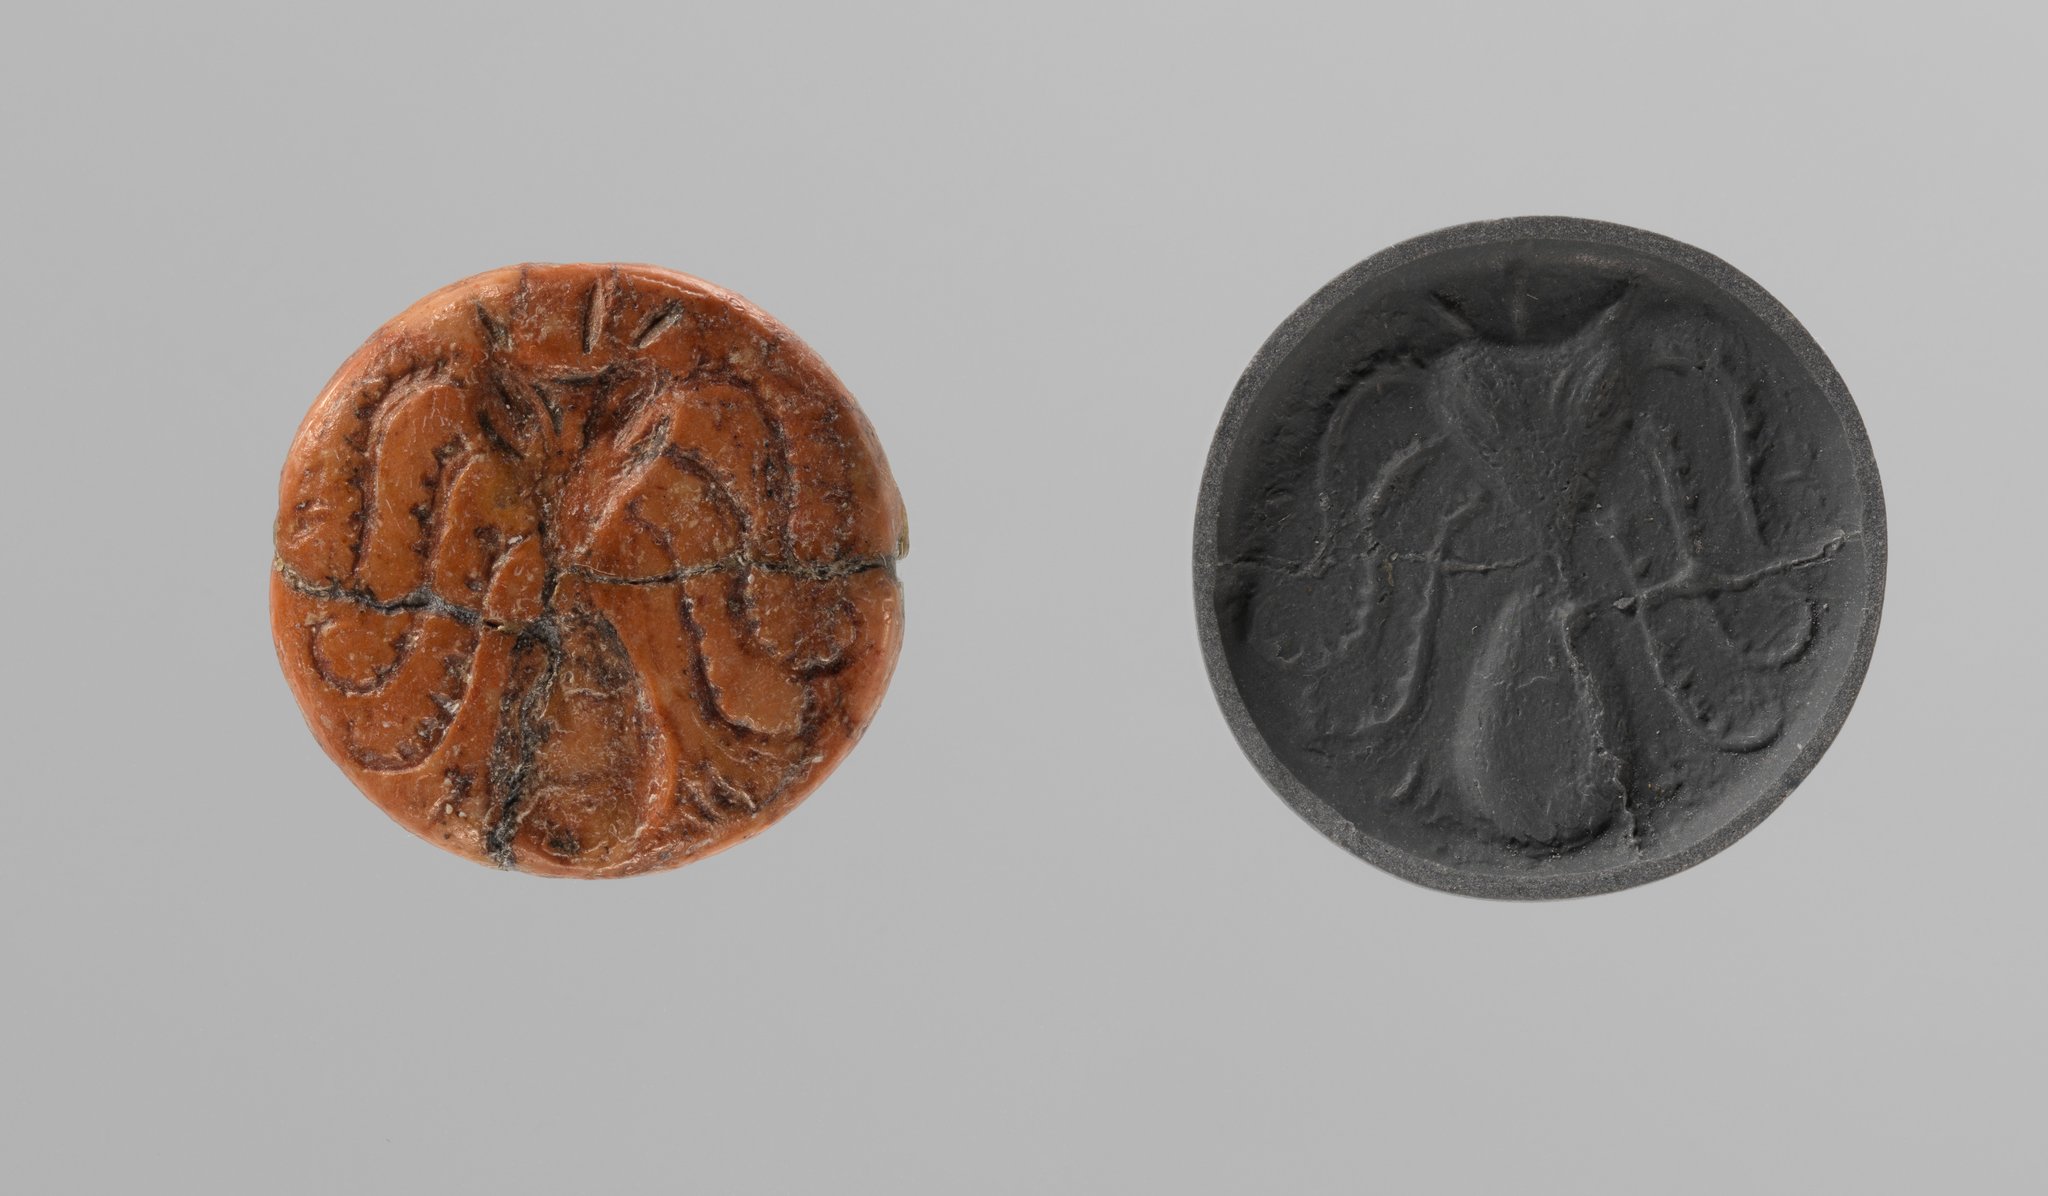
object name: seal, lentoid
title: Marble Lentoid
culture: minoan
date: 1450-1375 BCE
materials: marble